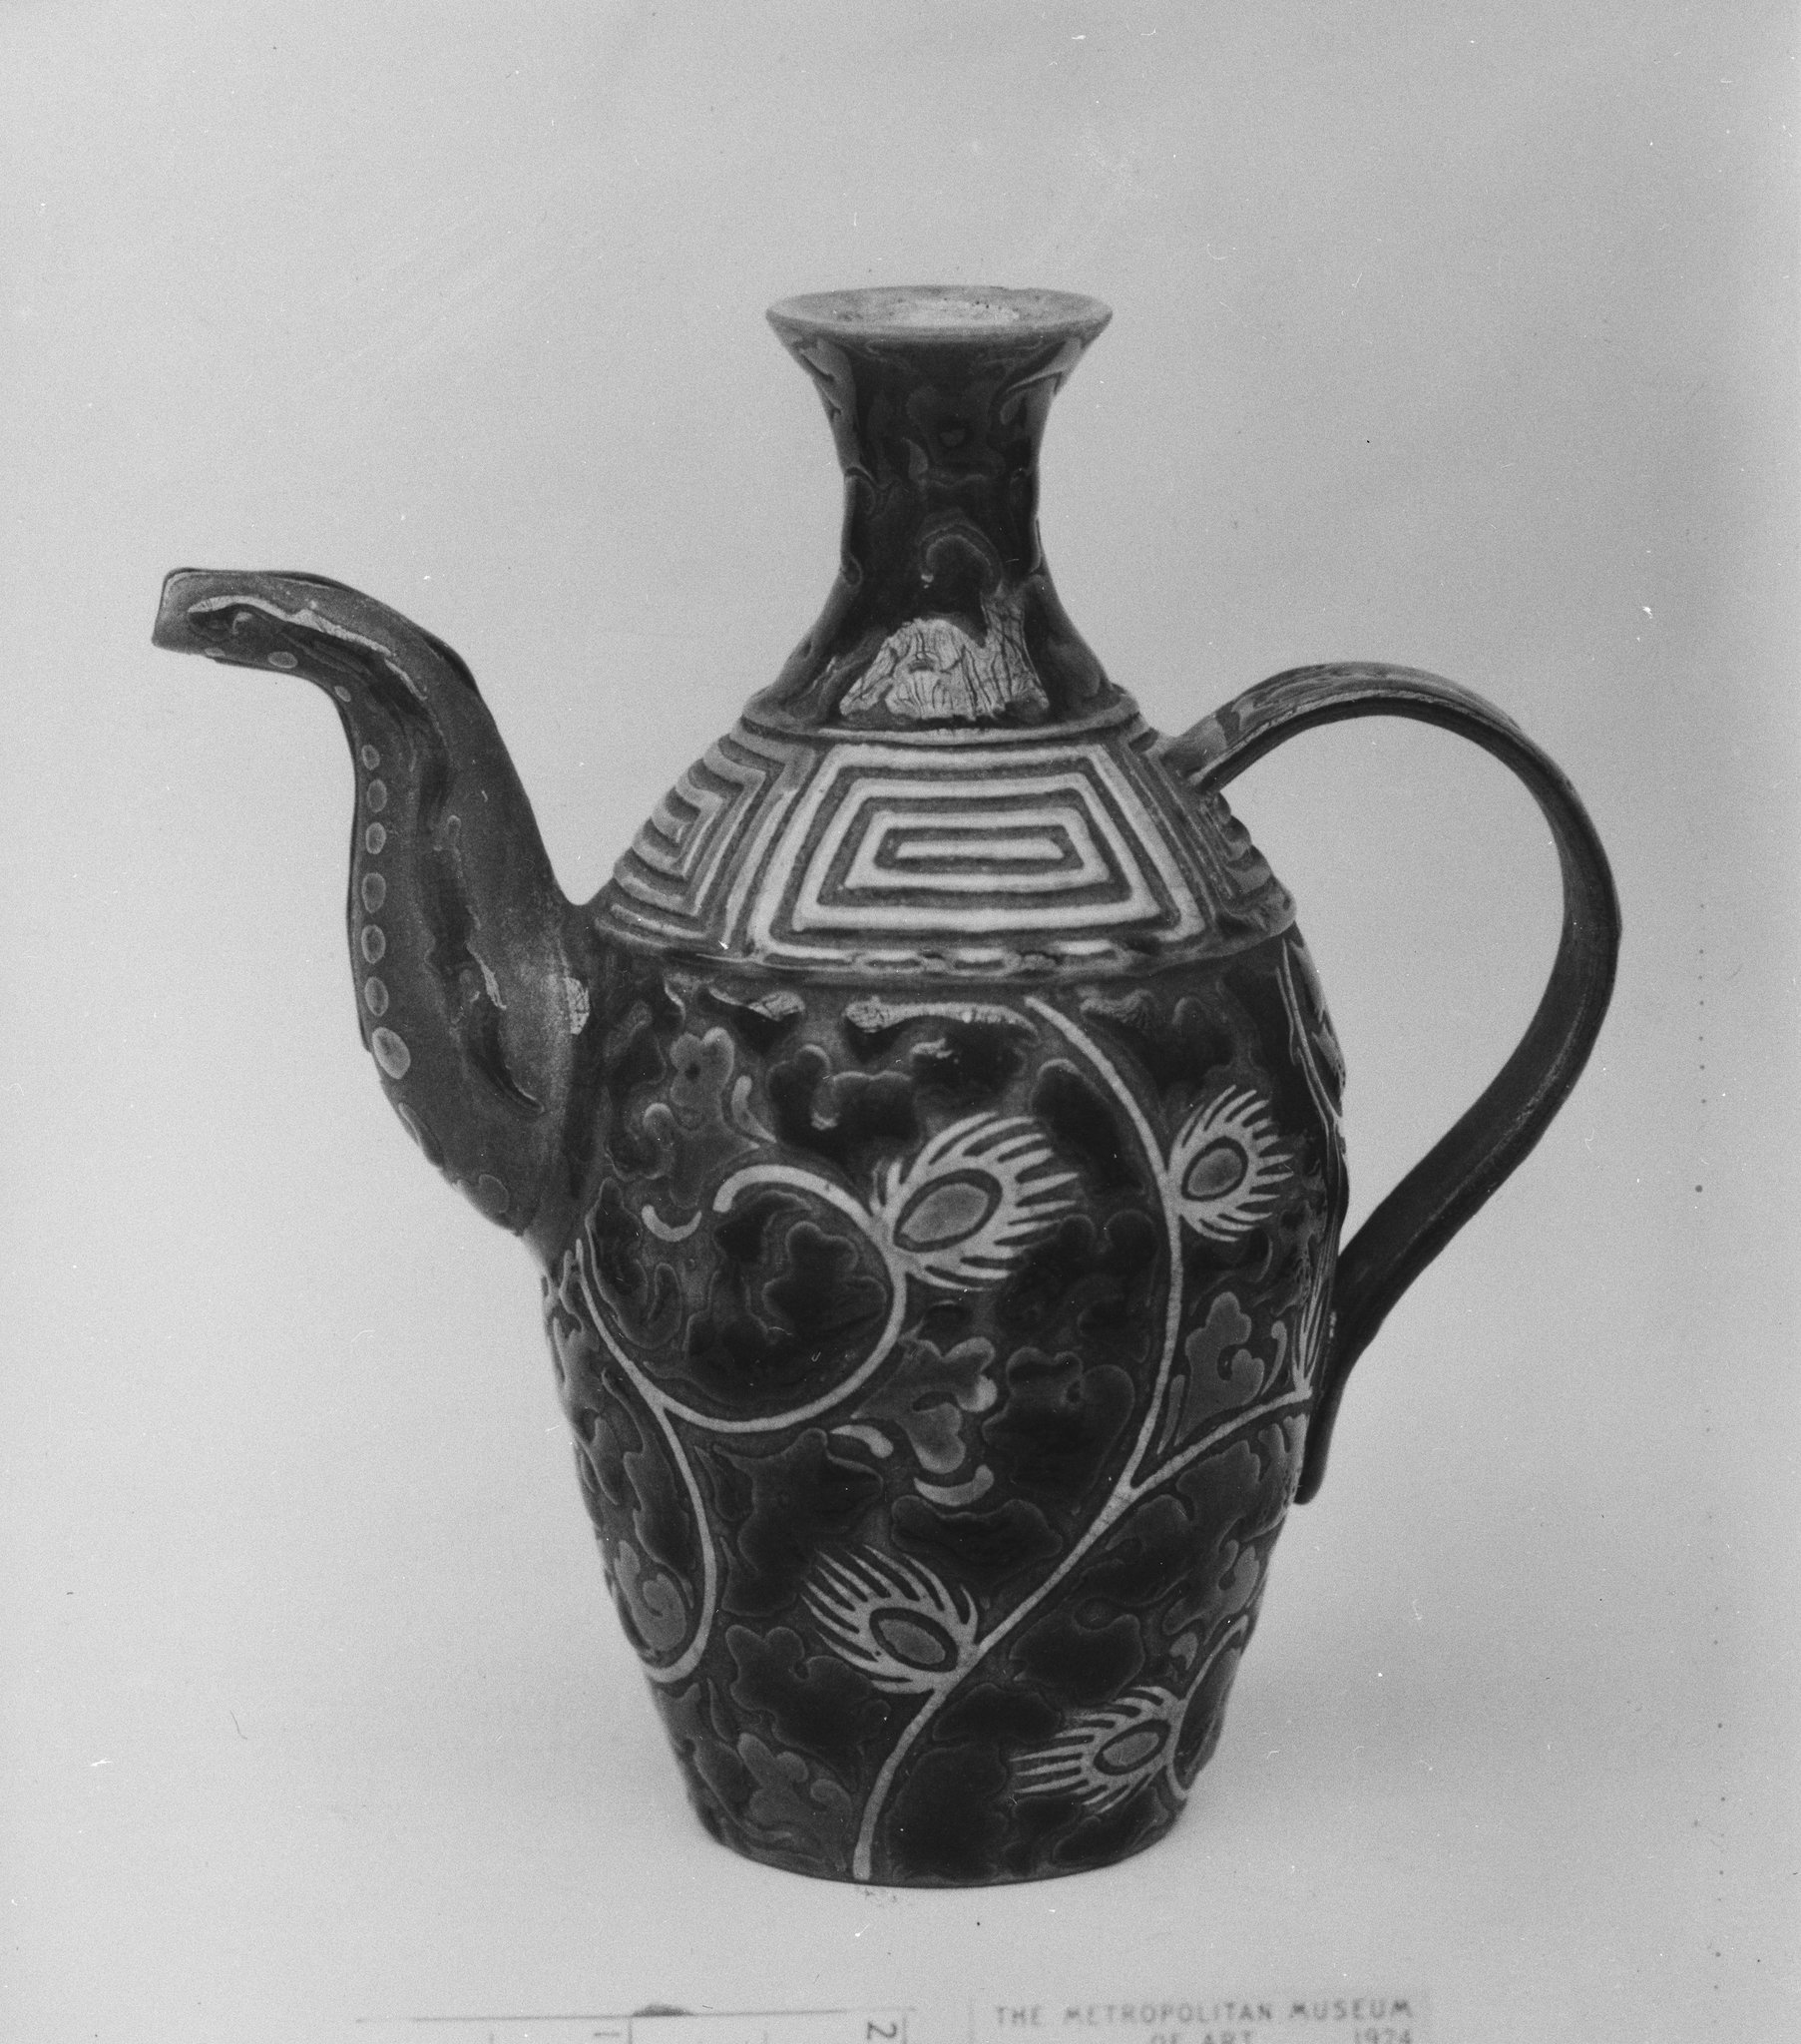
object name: wine pot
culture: japanese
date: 1790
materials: enamel, faience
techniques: relief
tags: flowers